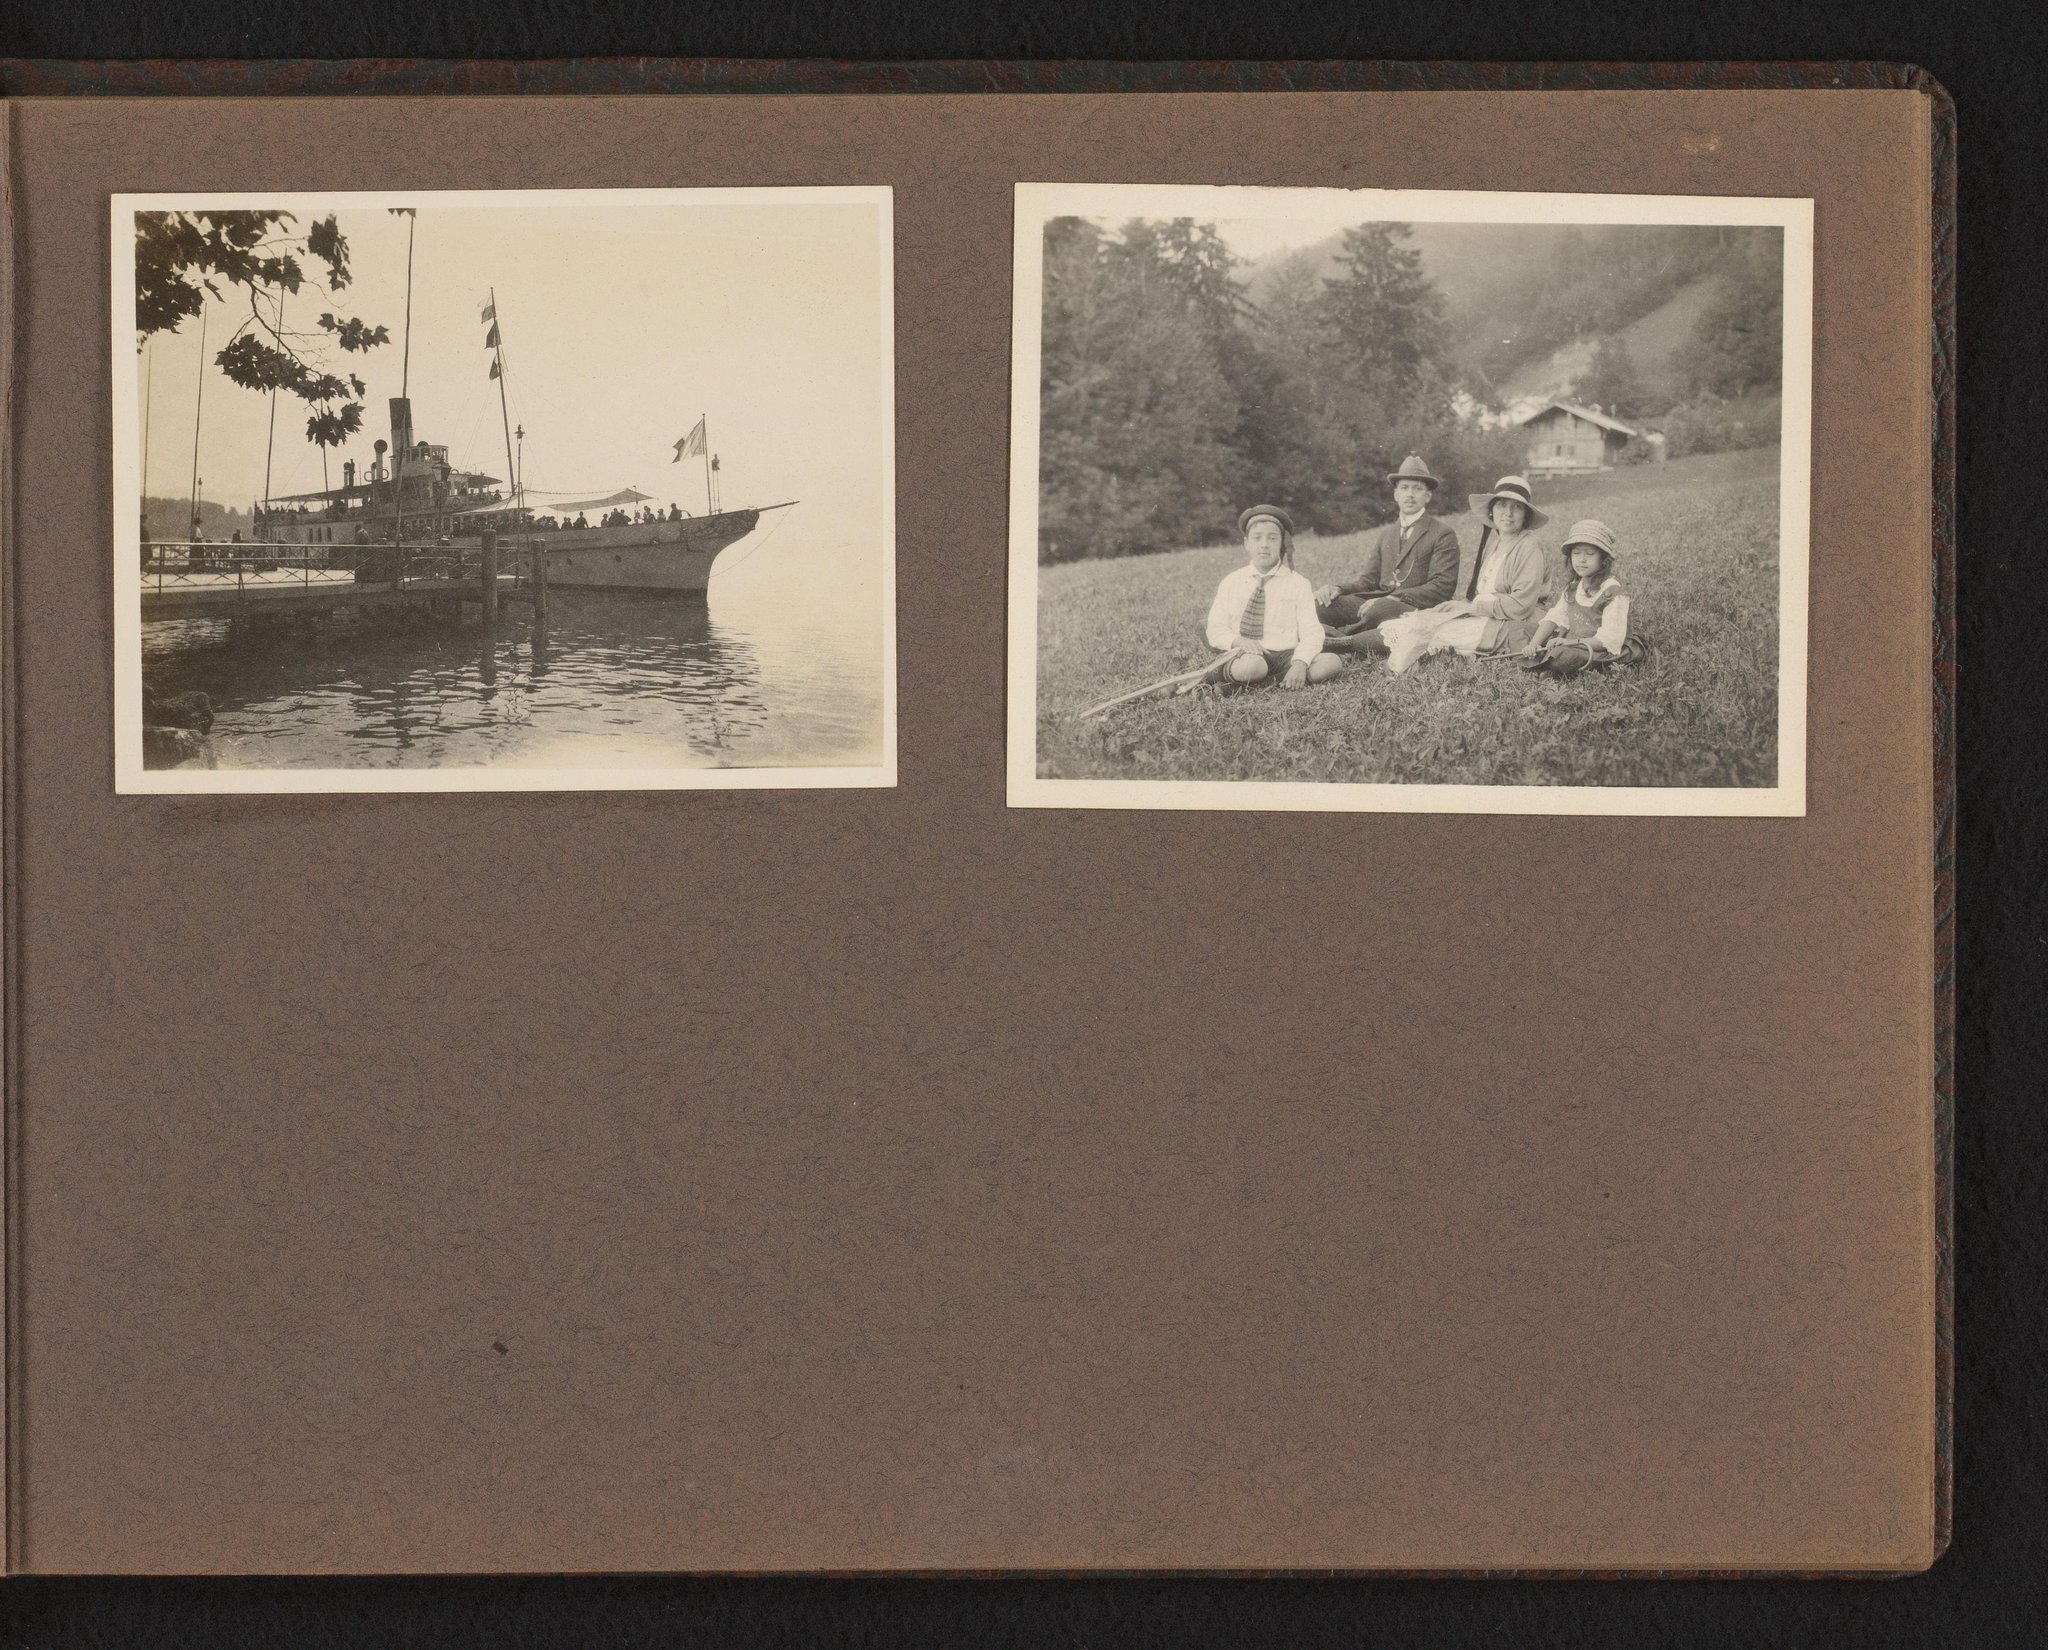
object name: photograph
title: Twee foto's van de familie op vakantie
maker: frédéric gabriël dumas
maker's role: engineer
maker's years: 1886-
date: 1919-1923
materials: cardboard, photographic support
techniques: gelatin silver print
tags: surabaya, engineer, frédéric gabriël dumas, paris, beatrice jacqueline eveline dumas, java, outing, pleasure trip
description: Blad met tweee foto's van de familie op vakantie, mogelijk Zwitserland. Onderdeel van een fotoalbum over de kindertijd van Eef Dumas met de familie op reis door Europa, ca. 1919-1923.